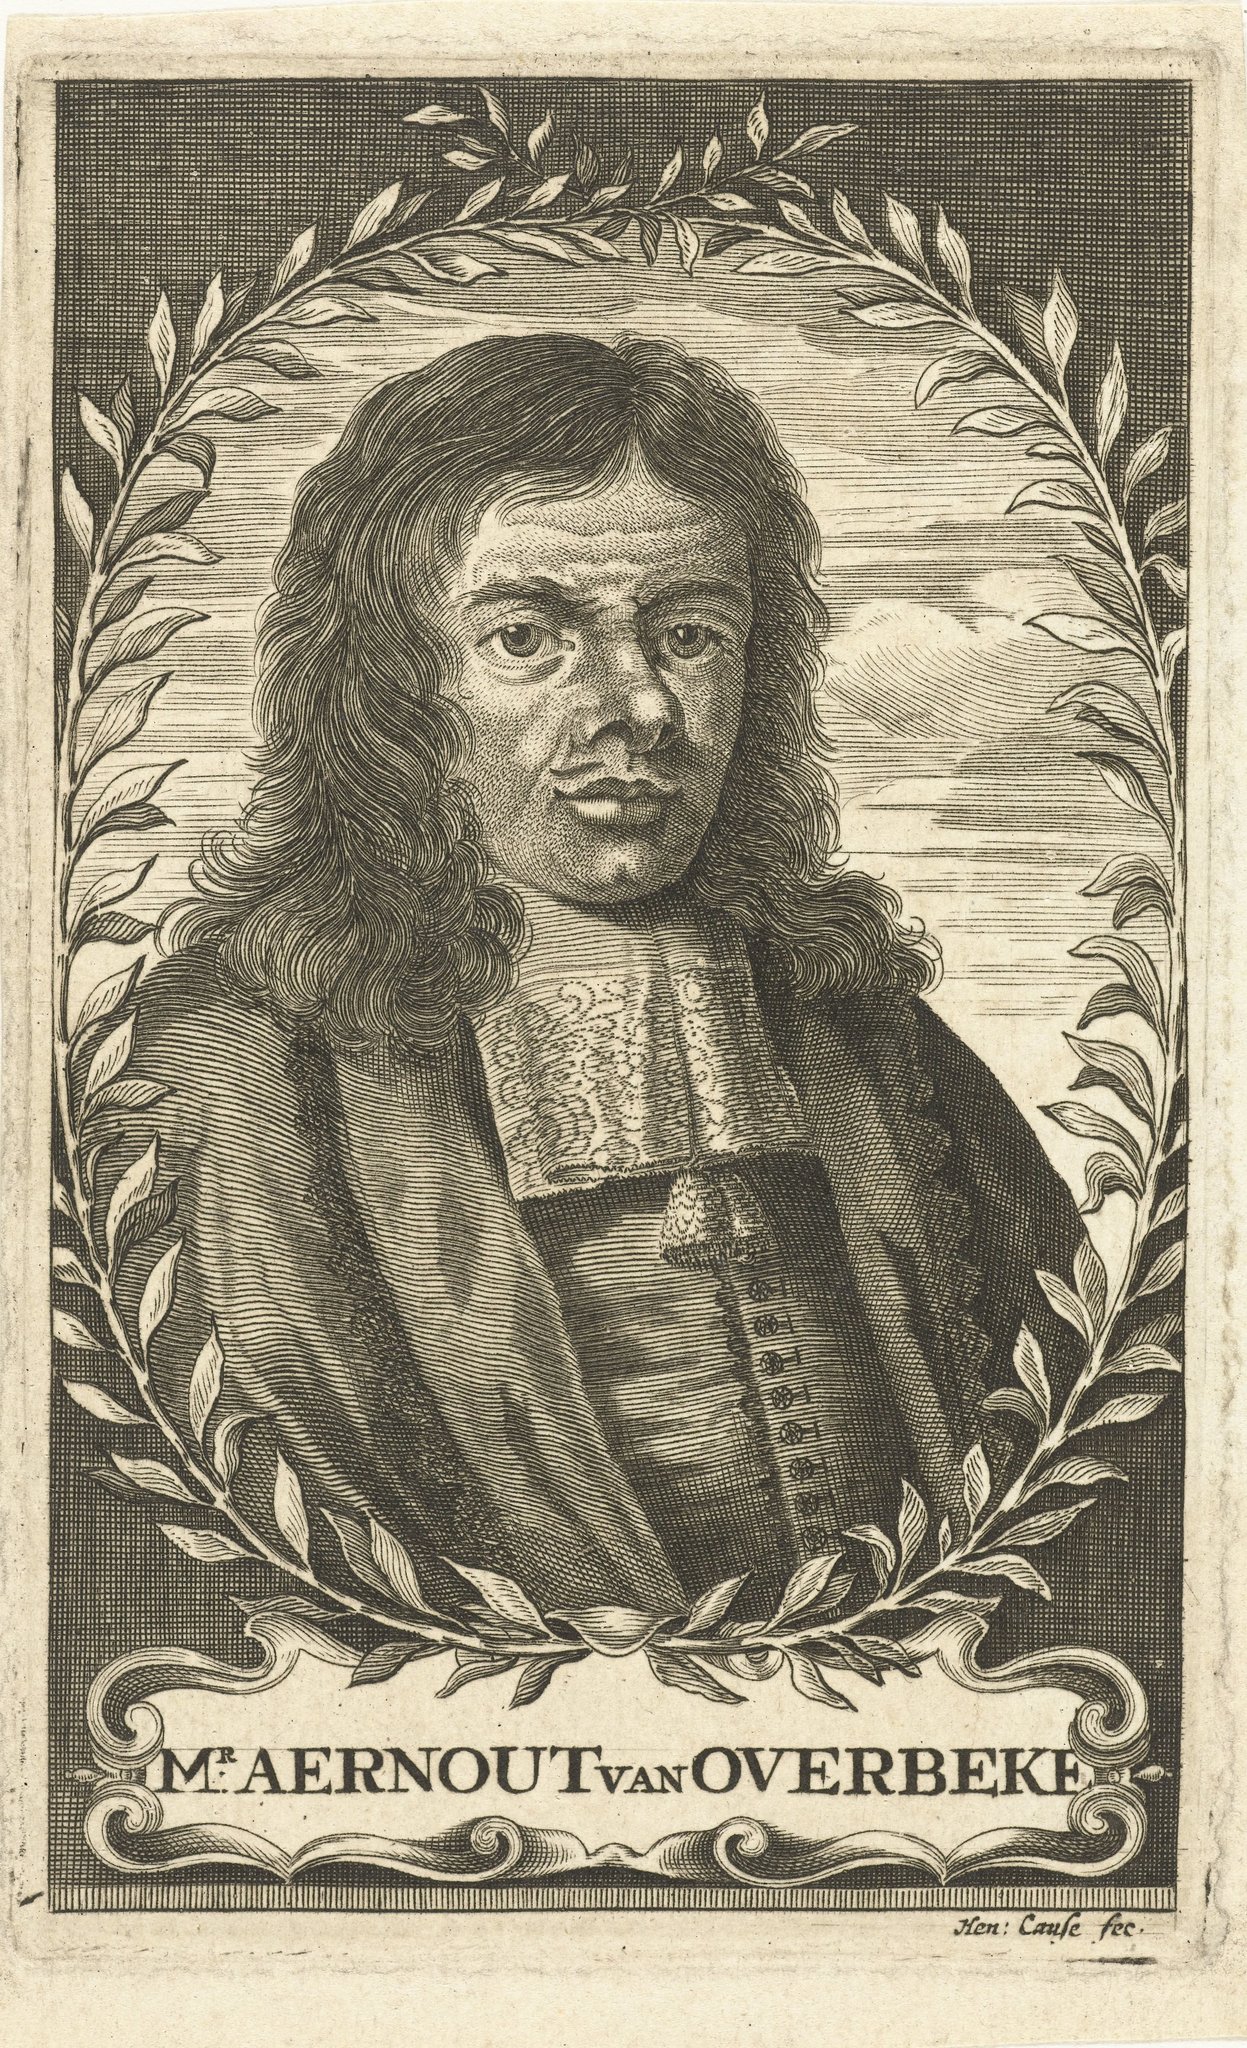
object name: print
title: Portret van Aernout van Overbeke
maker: hendrik causé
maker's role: print maker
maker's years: 1648-1699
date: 1663-1699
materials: paper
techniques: engraving, etching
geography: antwerp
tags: admiraal, aernout van overbeke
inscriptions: collector's mark: Lugt 2228